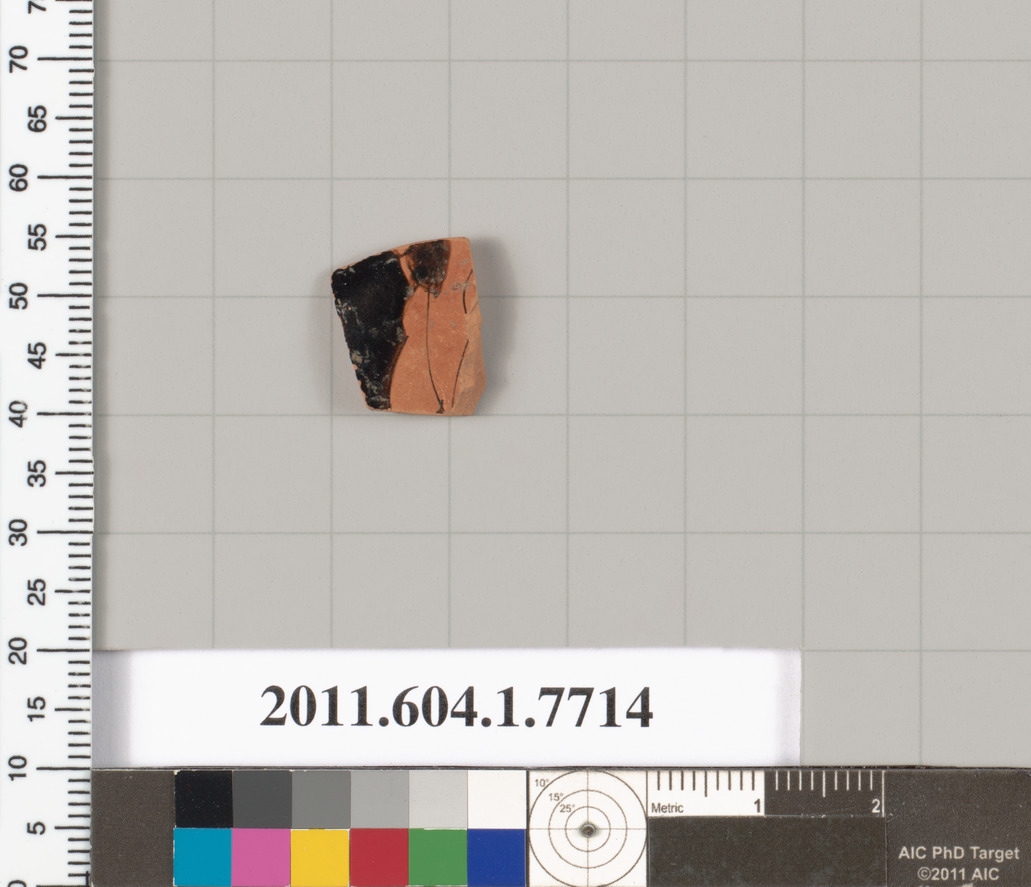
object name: kylix fragment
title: Terracotta fragment of a kylix (drinking cup)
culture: greek, attic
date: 460-450 BCE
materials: terracotta